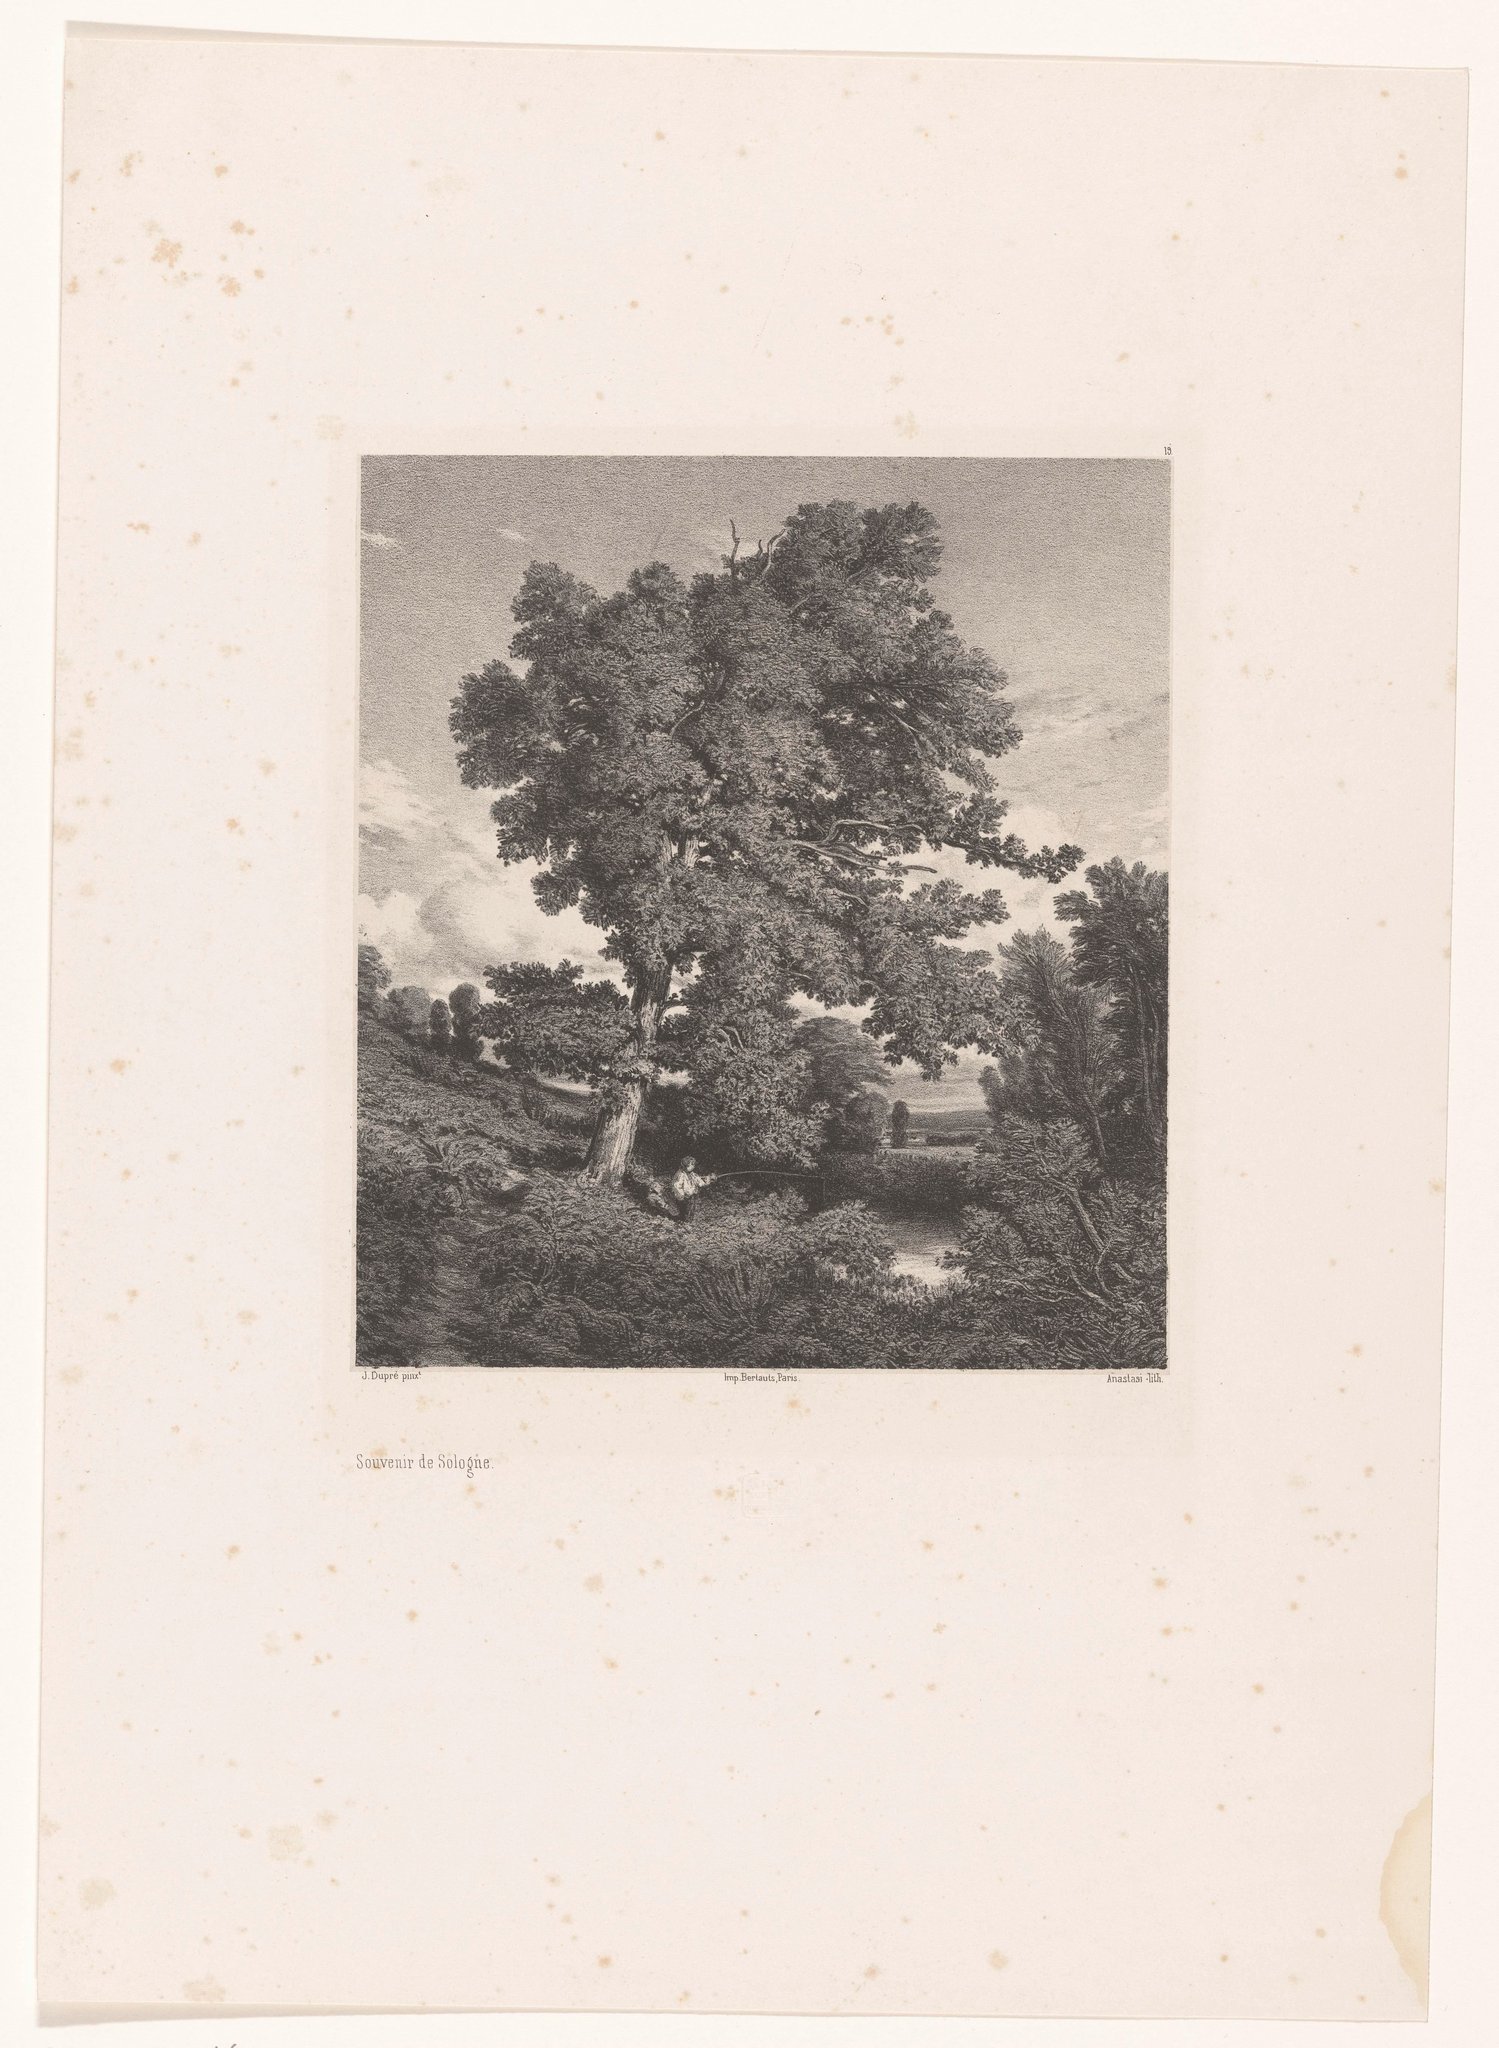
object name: print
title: Landschap met visser onder een eik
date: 1846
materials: paper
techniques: lithograph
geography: paris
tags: trees: oak, fishing (sports), pond, pool, fisherman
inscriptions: collector's mark: Lugt 2228, check stamp: Lugt 36b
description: Een visser staat met een hengel bij een vijver onder een grote eik in de (voormalige) provincie Berry (bij Bourges).